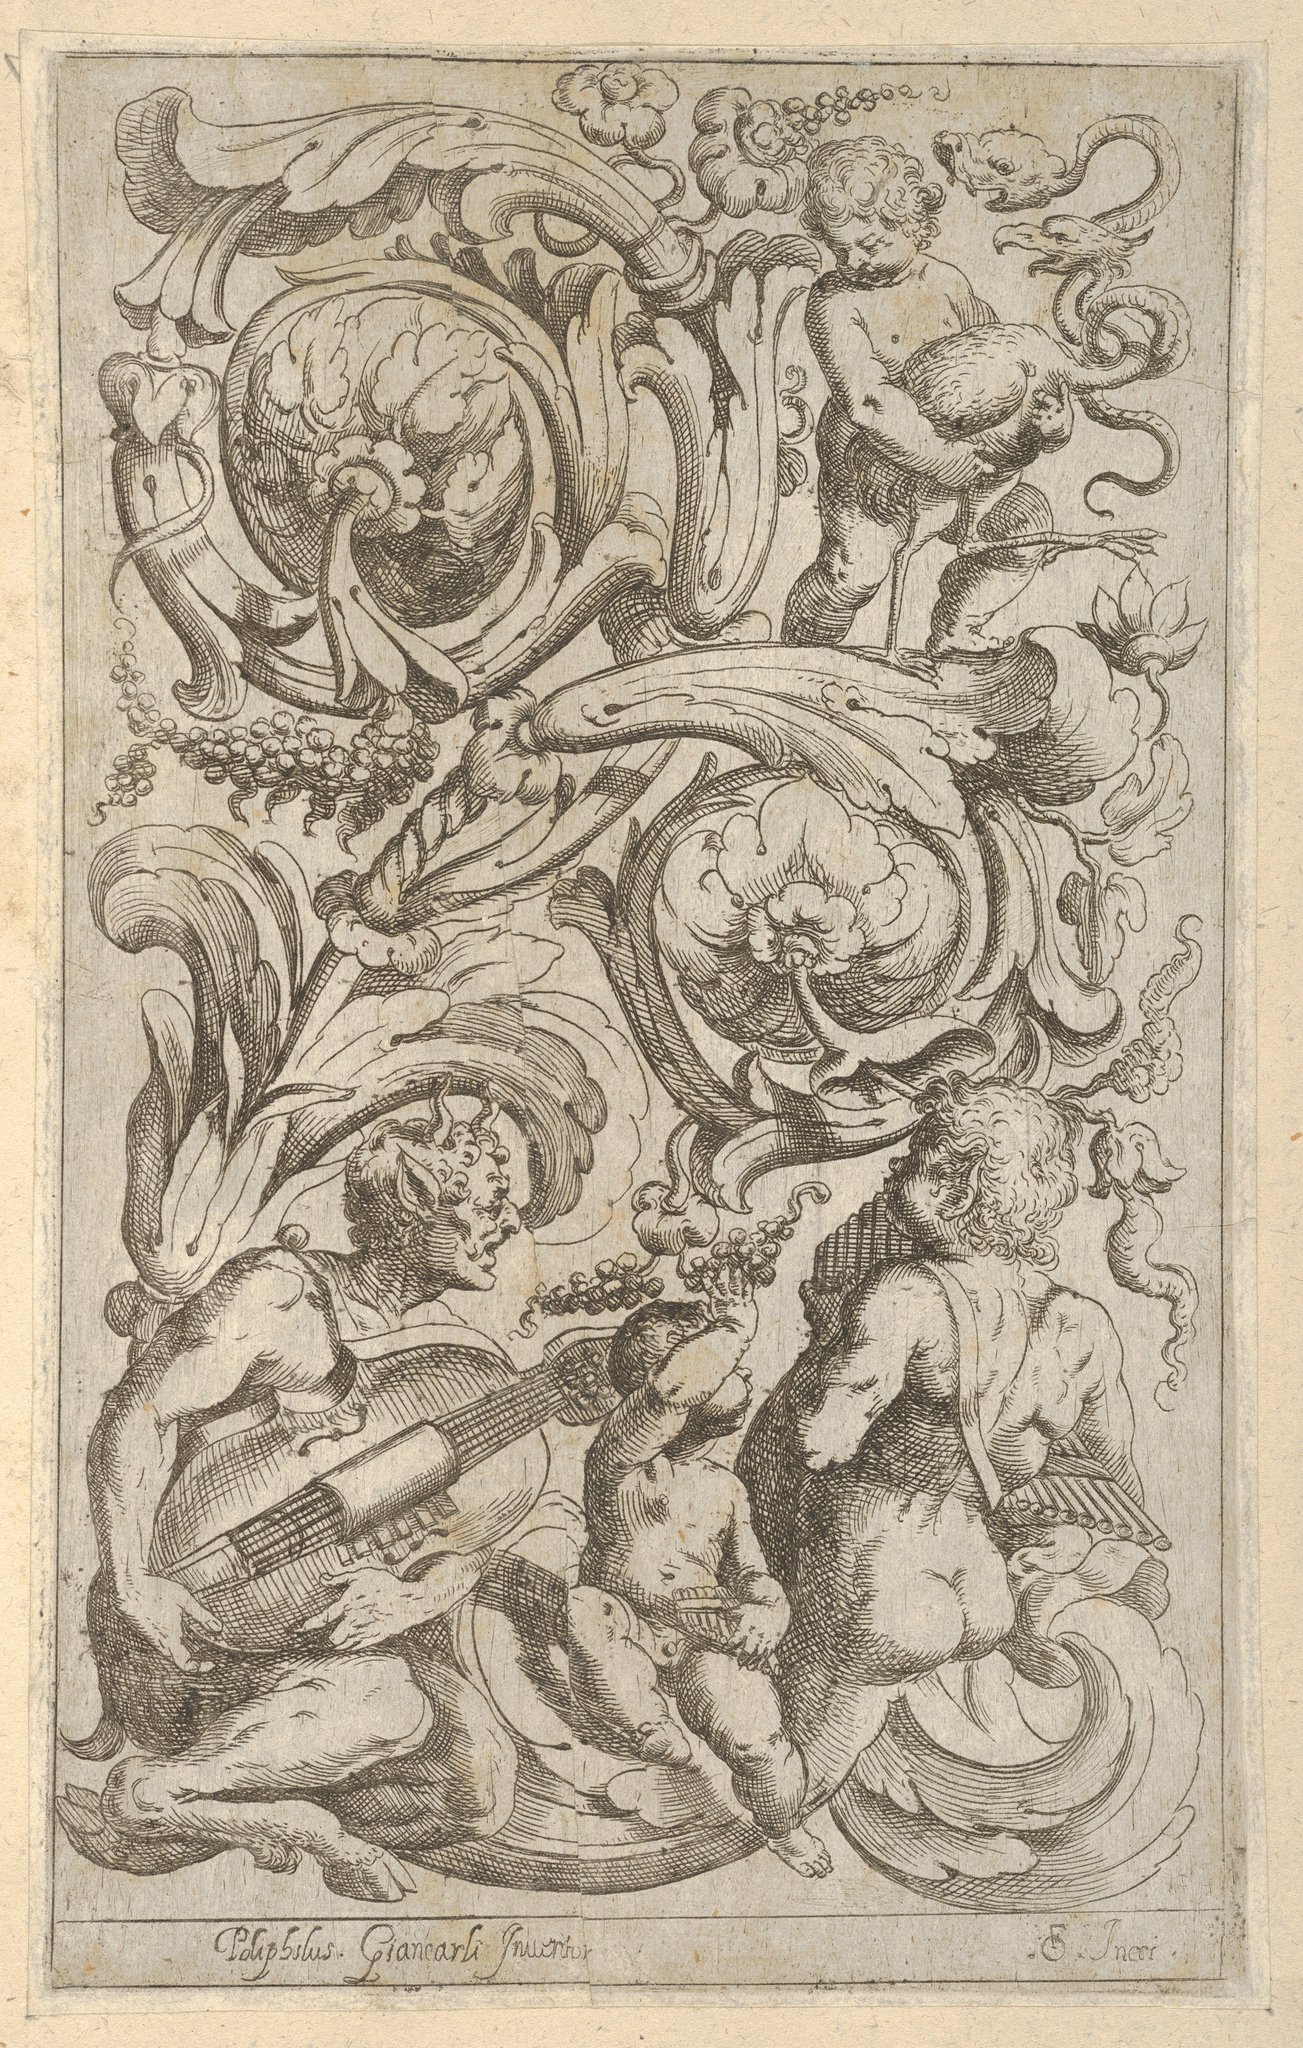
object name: collection ornament architecture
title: Disegni Varii di Polifilo Zancarli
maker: polifilo giancarli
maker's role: artist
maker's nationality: italian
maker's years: 1600-1625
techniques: etching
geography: italy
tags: musical instruments,putti,satyrs